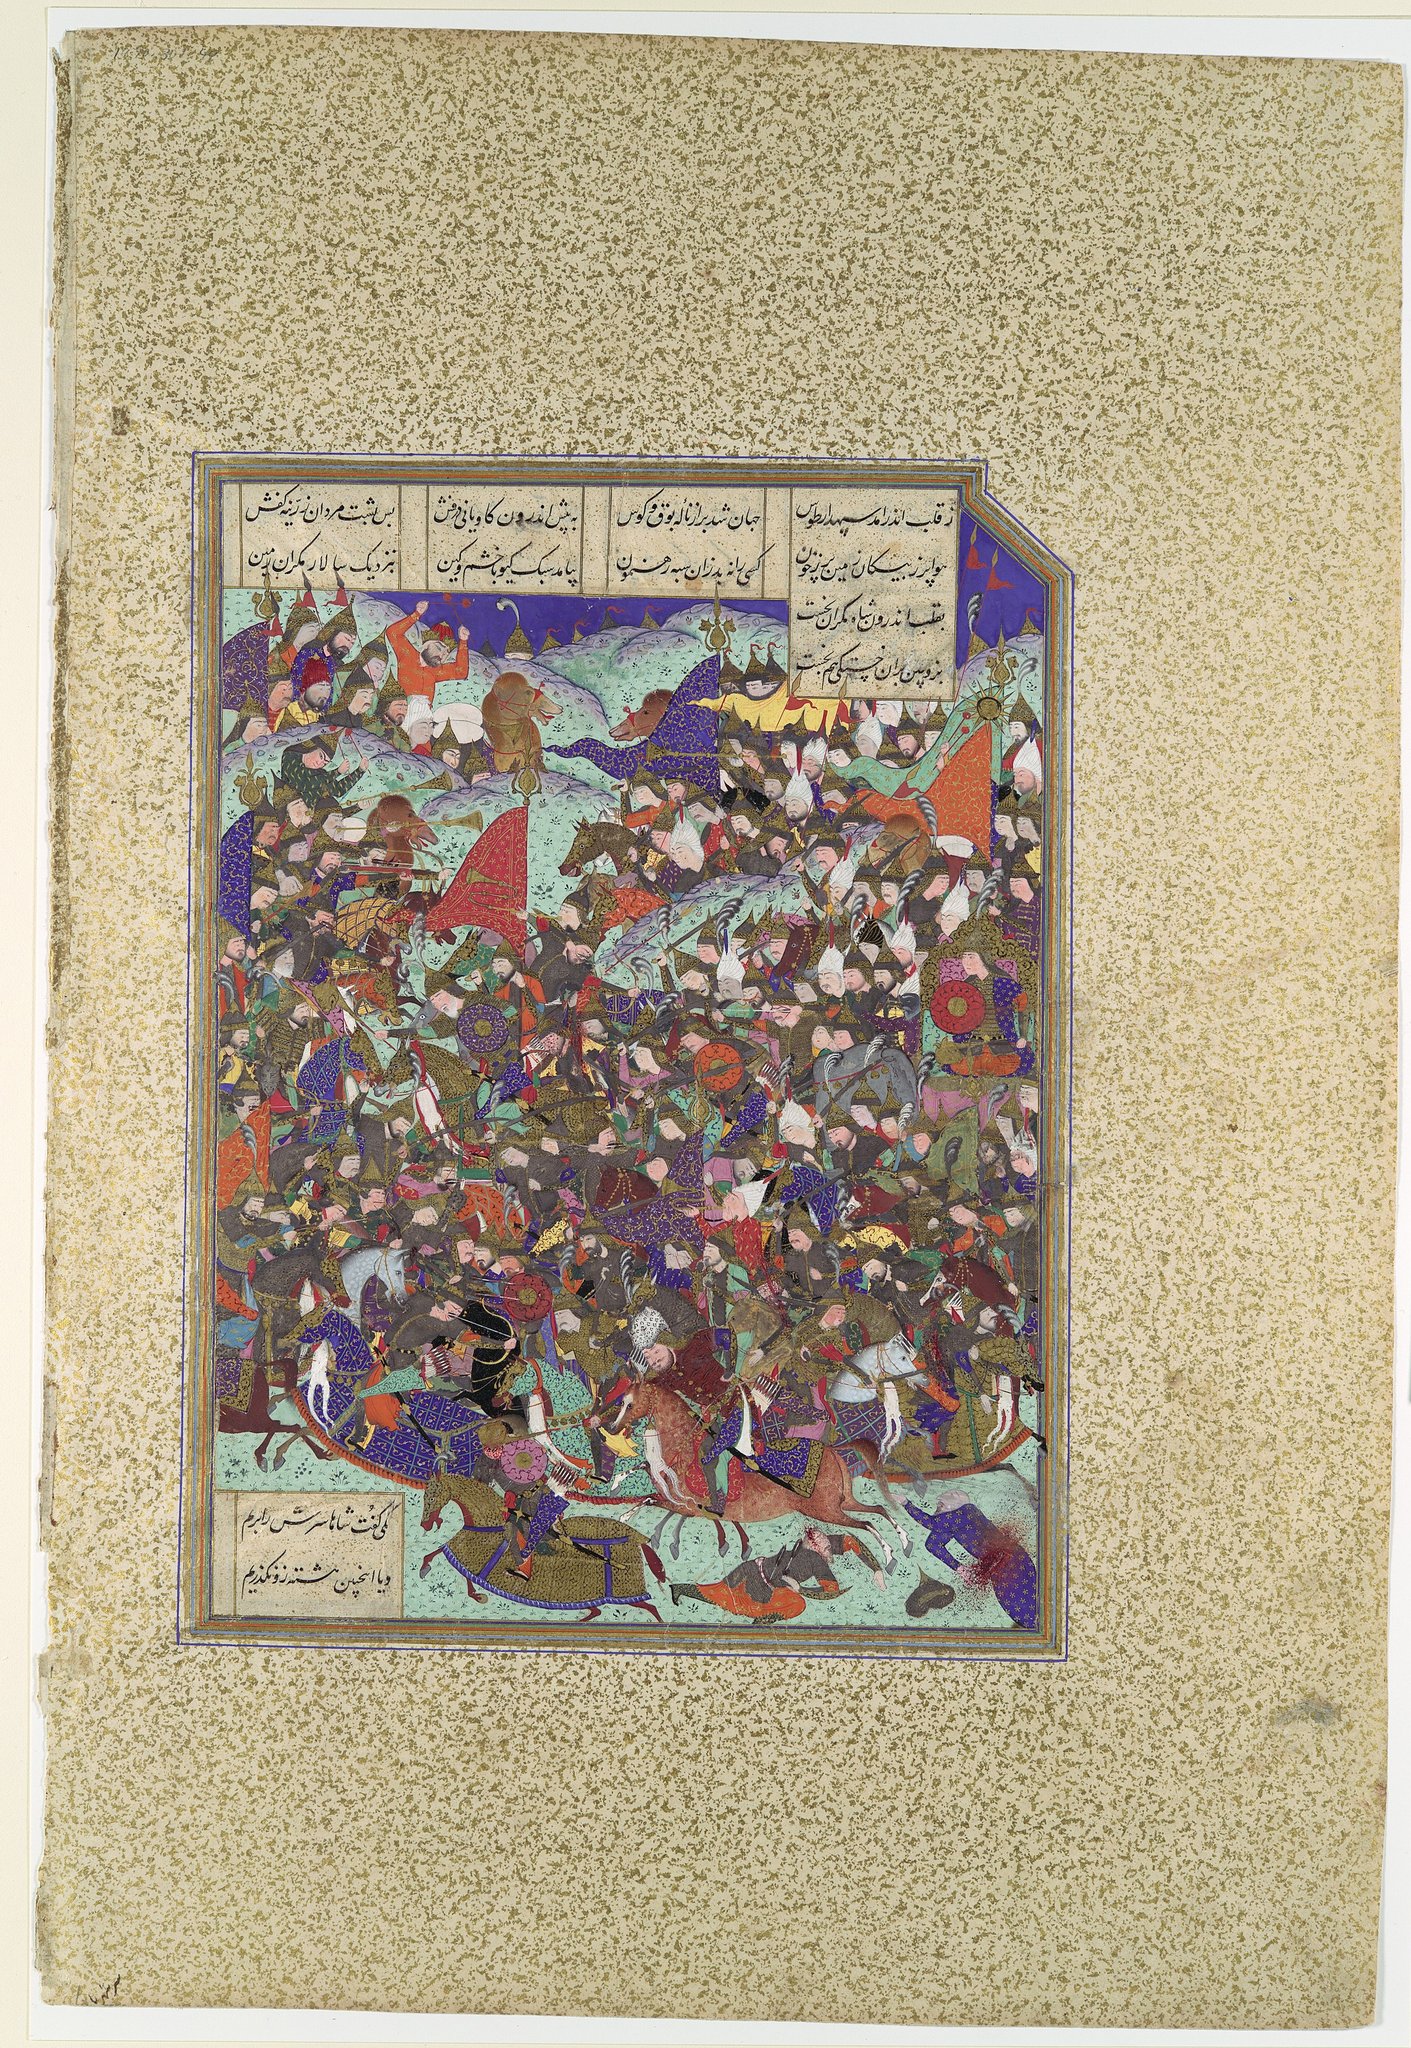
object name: folio from an illustrated manuscript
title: "Kai Khusrau Defeats the Army of Makran", Folio 376v from the Shahnama (Book of Kings) of Shah Tahmasp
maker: abu'l qasim firdausi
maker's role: author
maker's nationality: iranian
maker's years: 935-1020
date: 1525-1530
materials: gold, ink, paper, silver, watercolor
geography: iran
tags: battles,men,horses